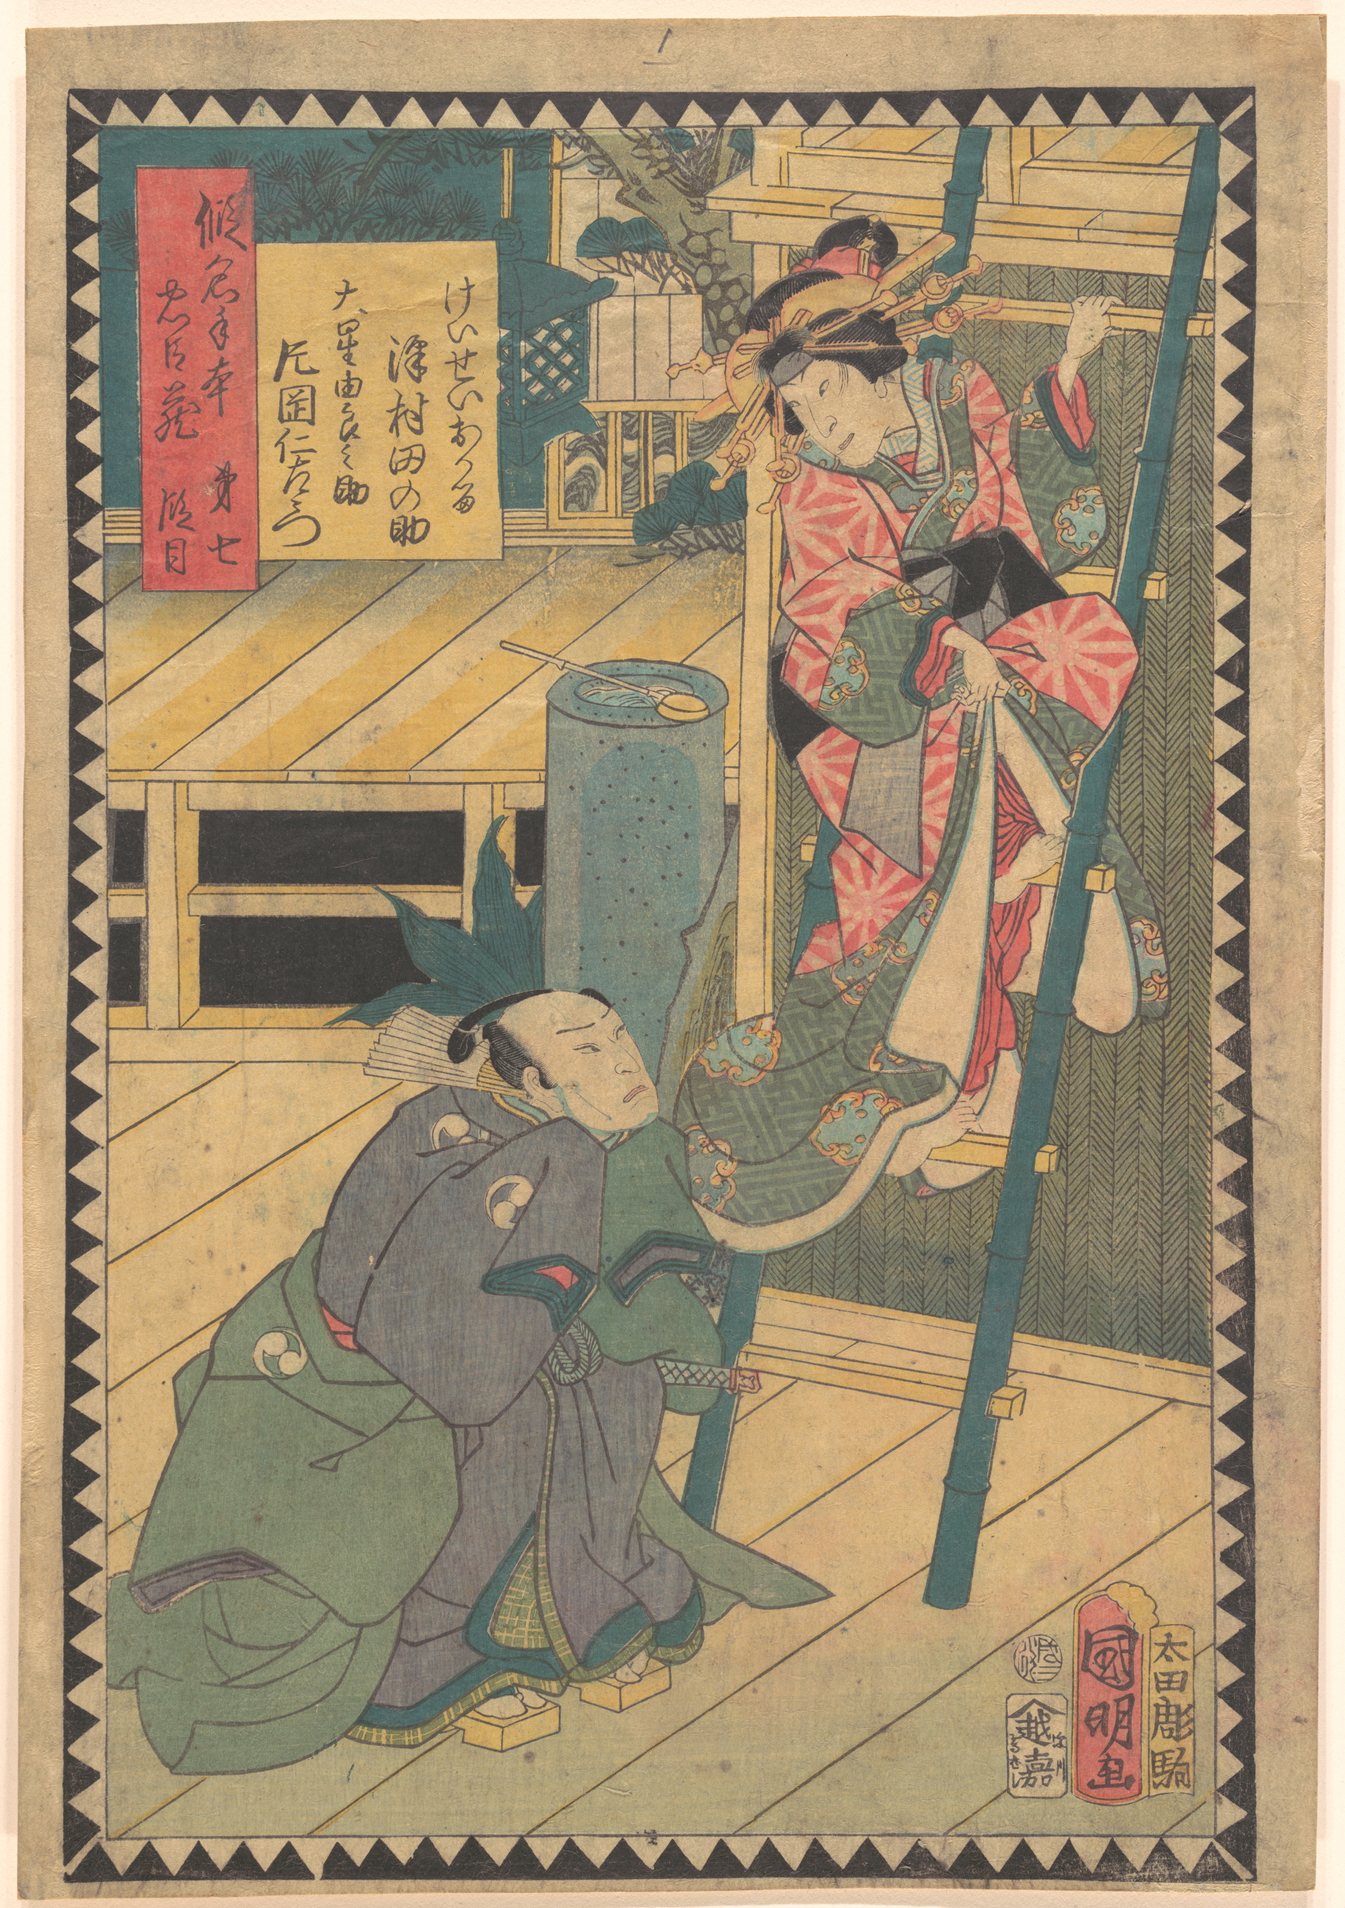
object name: print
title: Act III (Dai sandanme): Actors Bandō Hikosaburō V as Hayano Kanpei and Sawamura Tanosuke III as Koshimoto Okaru, from the series The Storehouse of Loyal Retainers, a Primer (Kanadehon chūshingura)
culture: japanese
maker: utagawa kuniaki ii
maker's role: artist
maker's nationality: japanese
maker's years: 1835-1888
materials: ink, paper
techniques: woodblock print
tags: men,women,actors